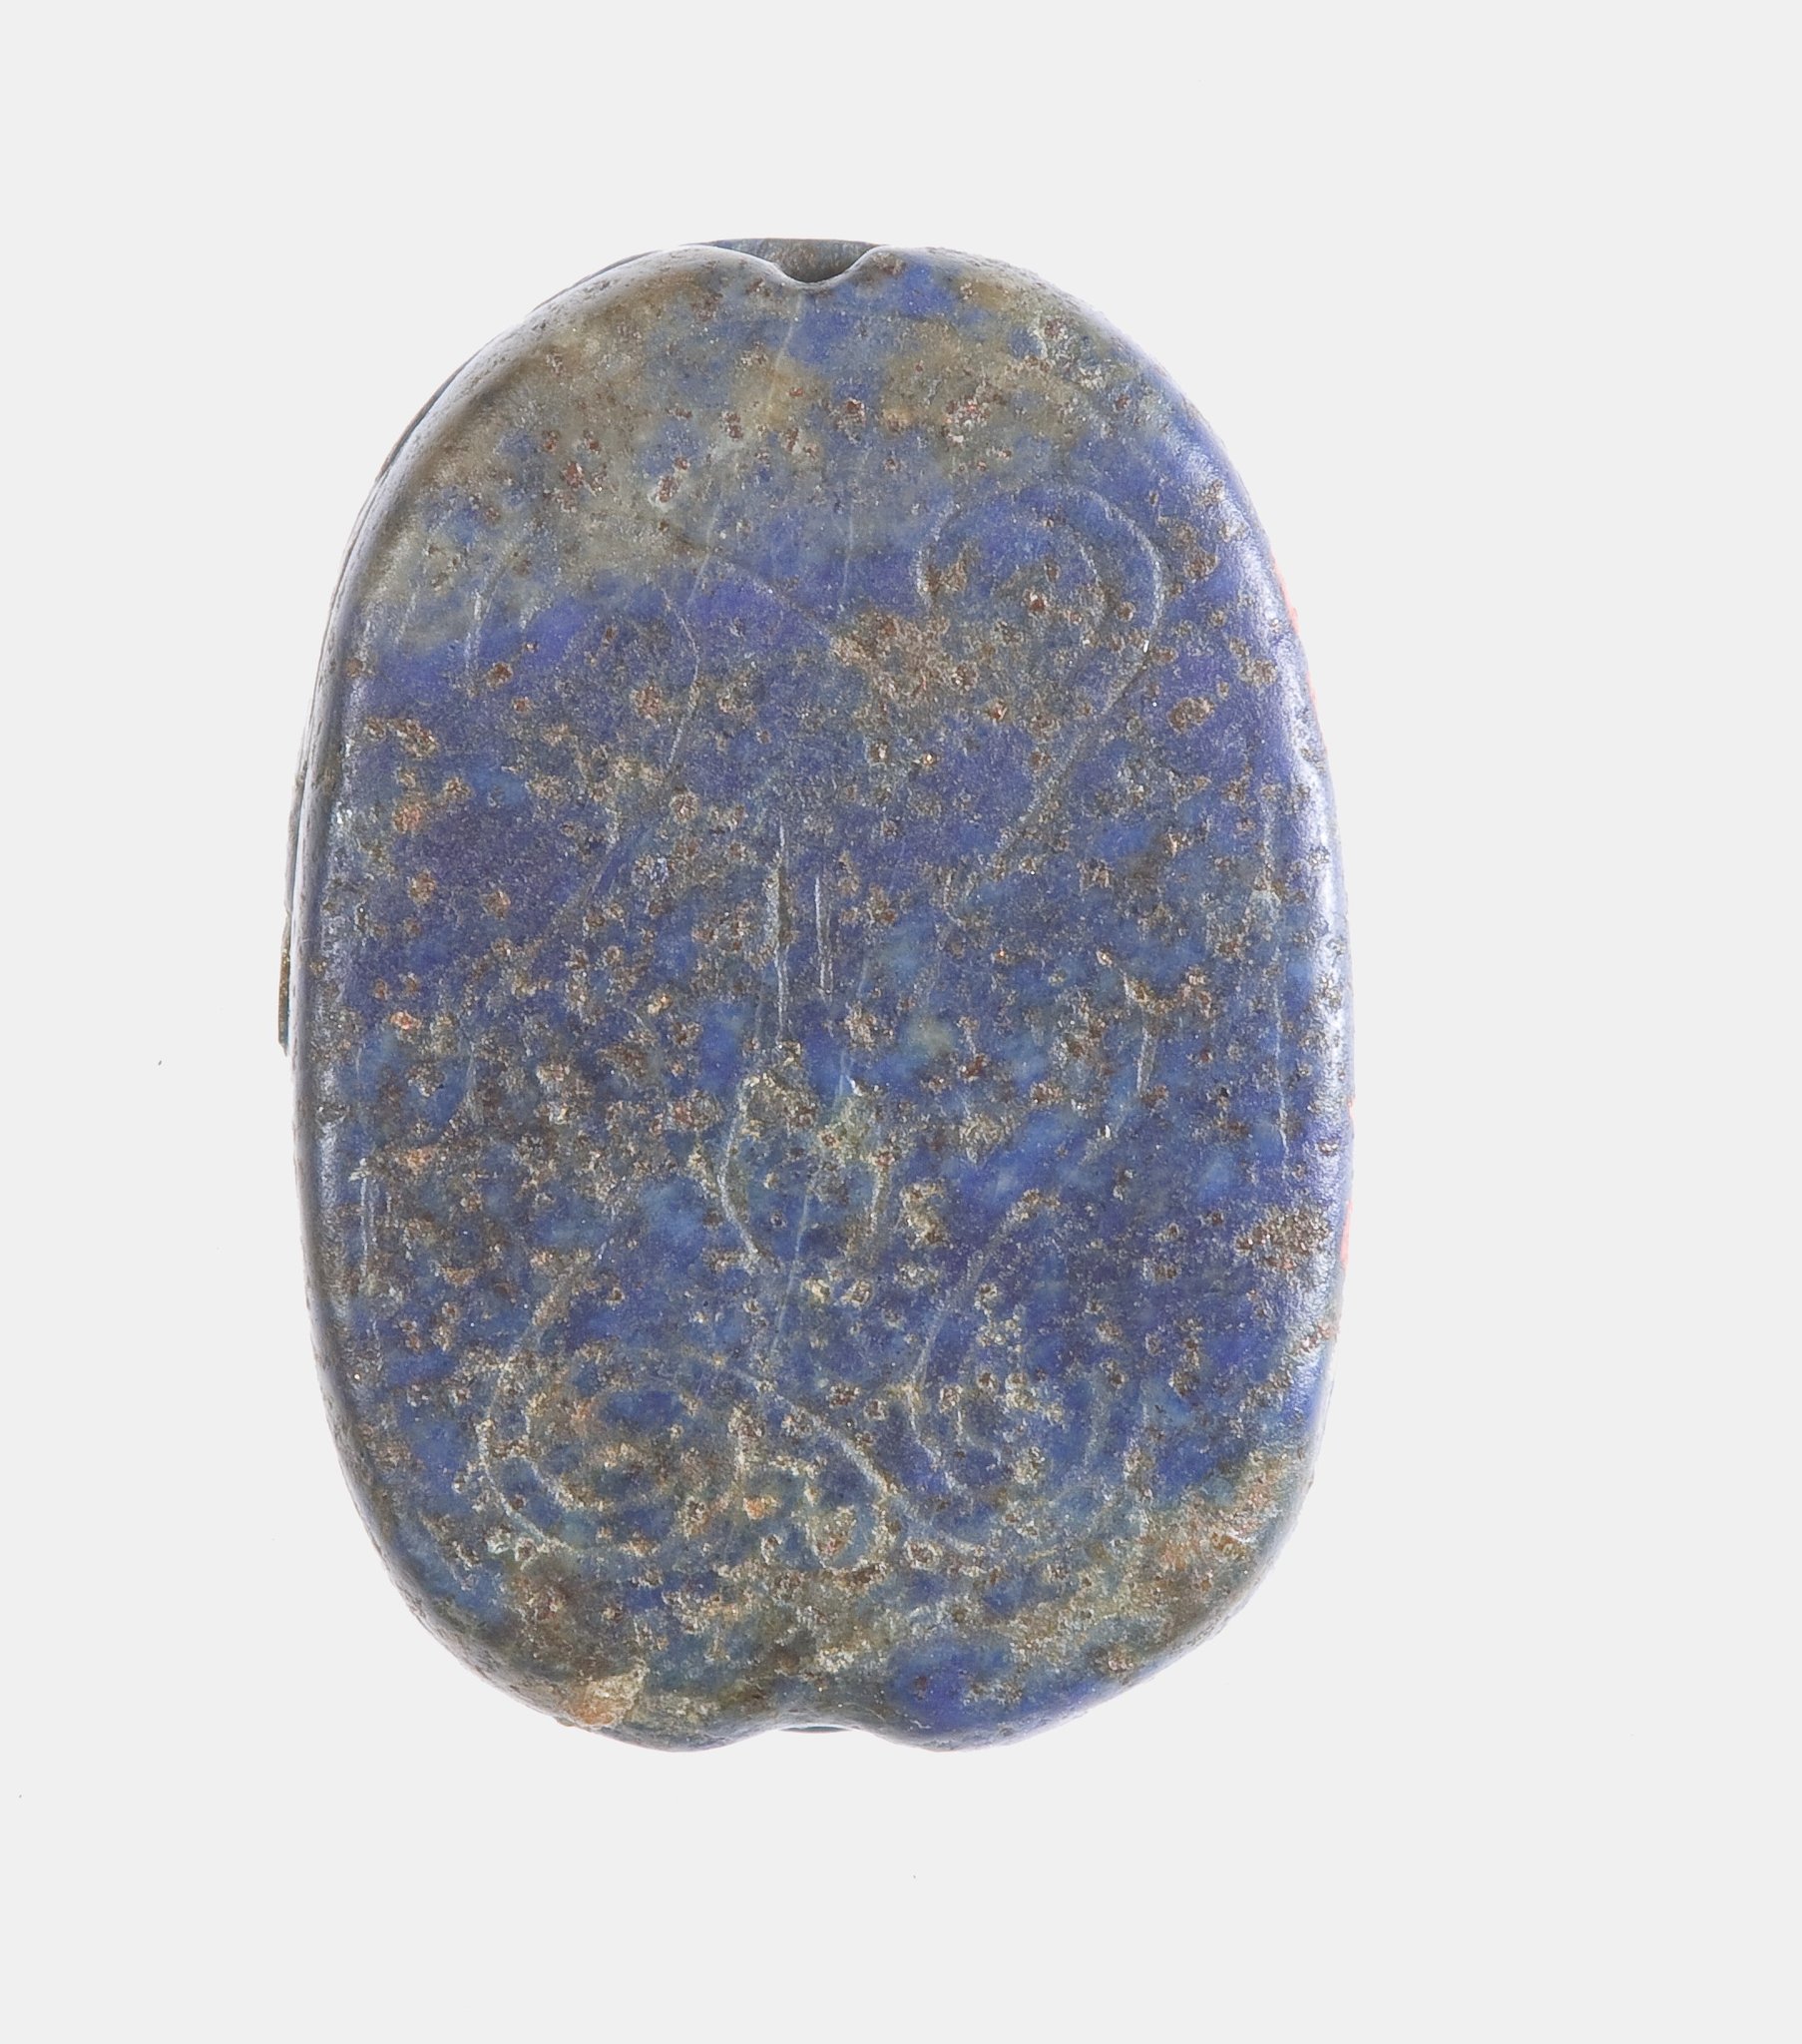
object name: scarab, satsobek, scroll, nefer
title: Scarab Inscribed with Nefer in Scroll Border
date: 1850-1640 BCE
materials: lapis lazuli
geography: egypt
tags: scarabs